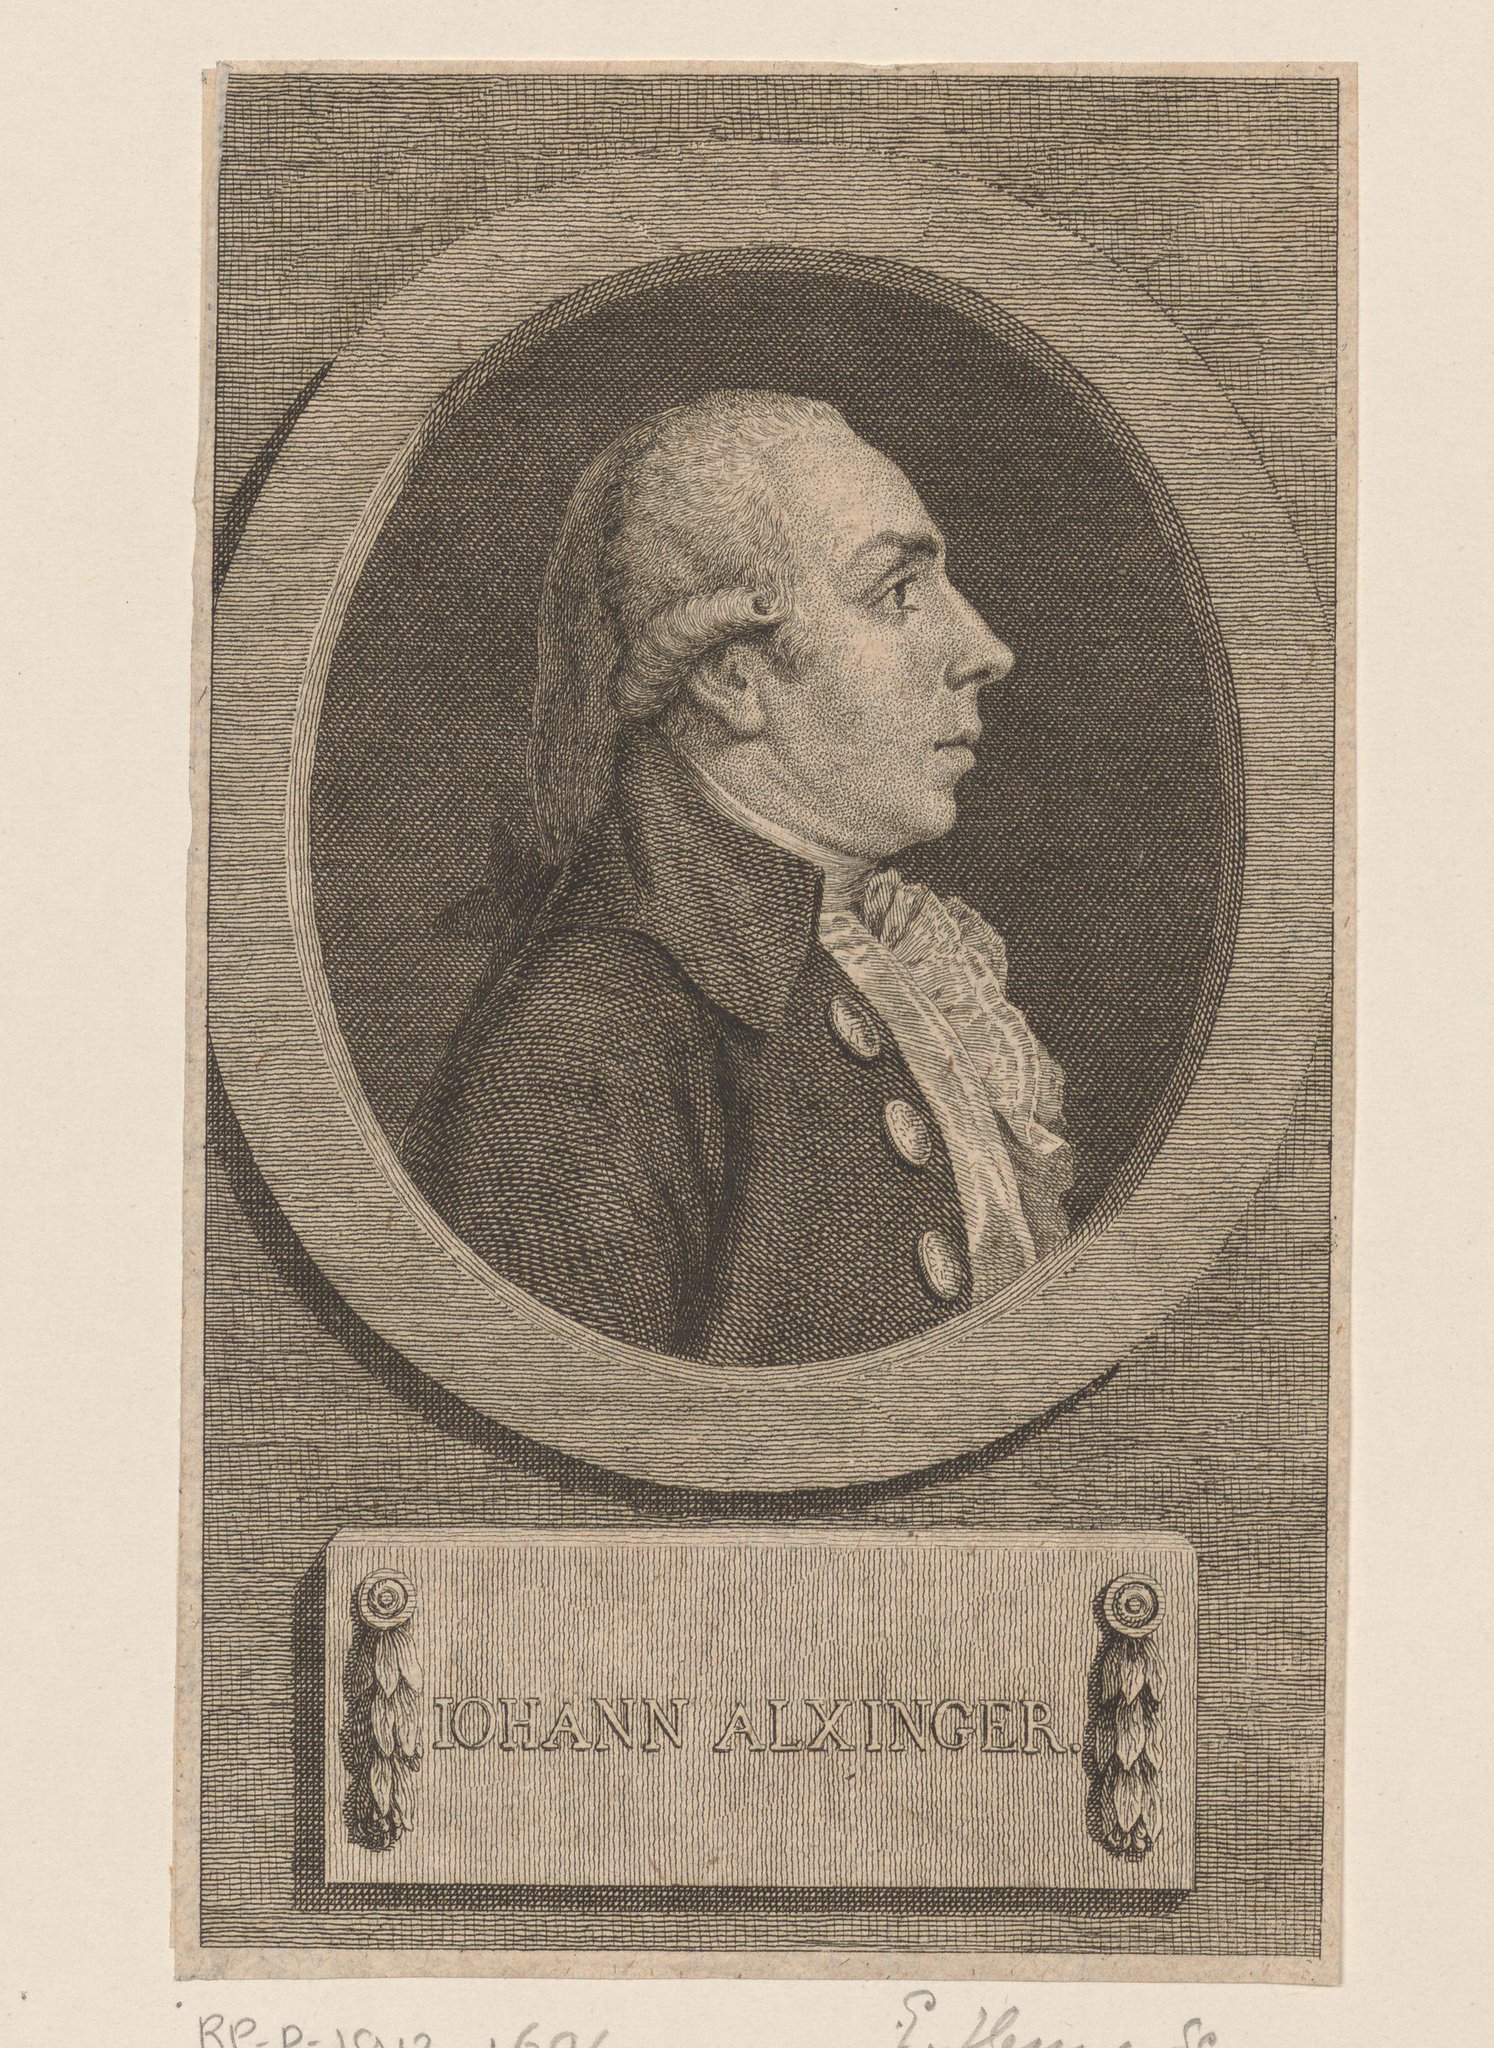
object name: print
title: Portret van Johann Baptist von Alxinger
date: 1789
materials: paper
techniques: etching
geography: berlin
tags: vienna, historical persons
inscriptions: collector's mark: Lugt 2228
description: Prent uit: Allgemeine deutsche Bibliothek. Berlijn en Stettin: Friedrich Nicolai, 1789, dl. 86.